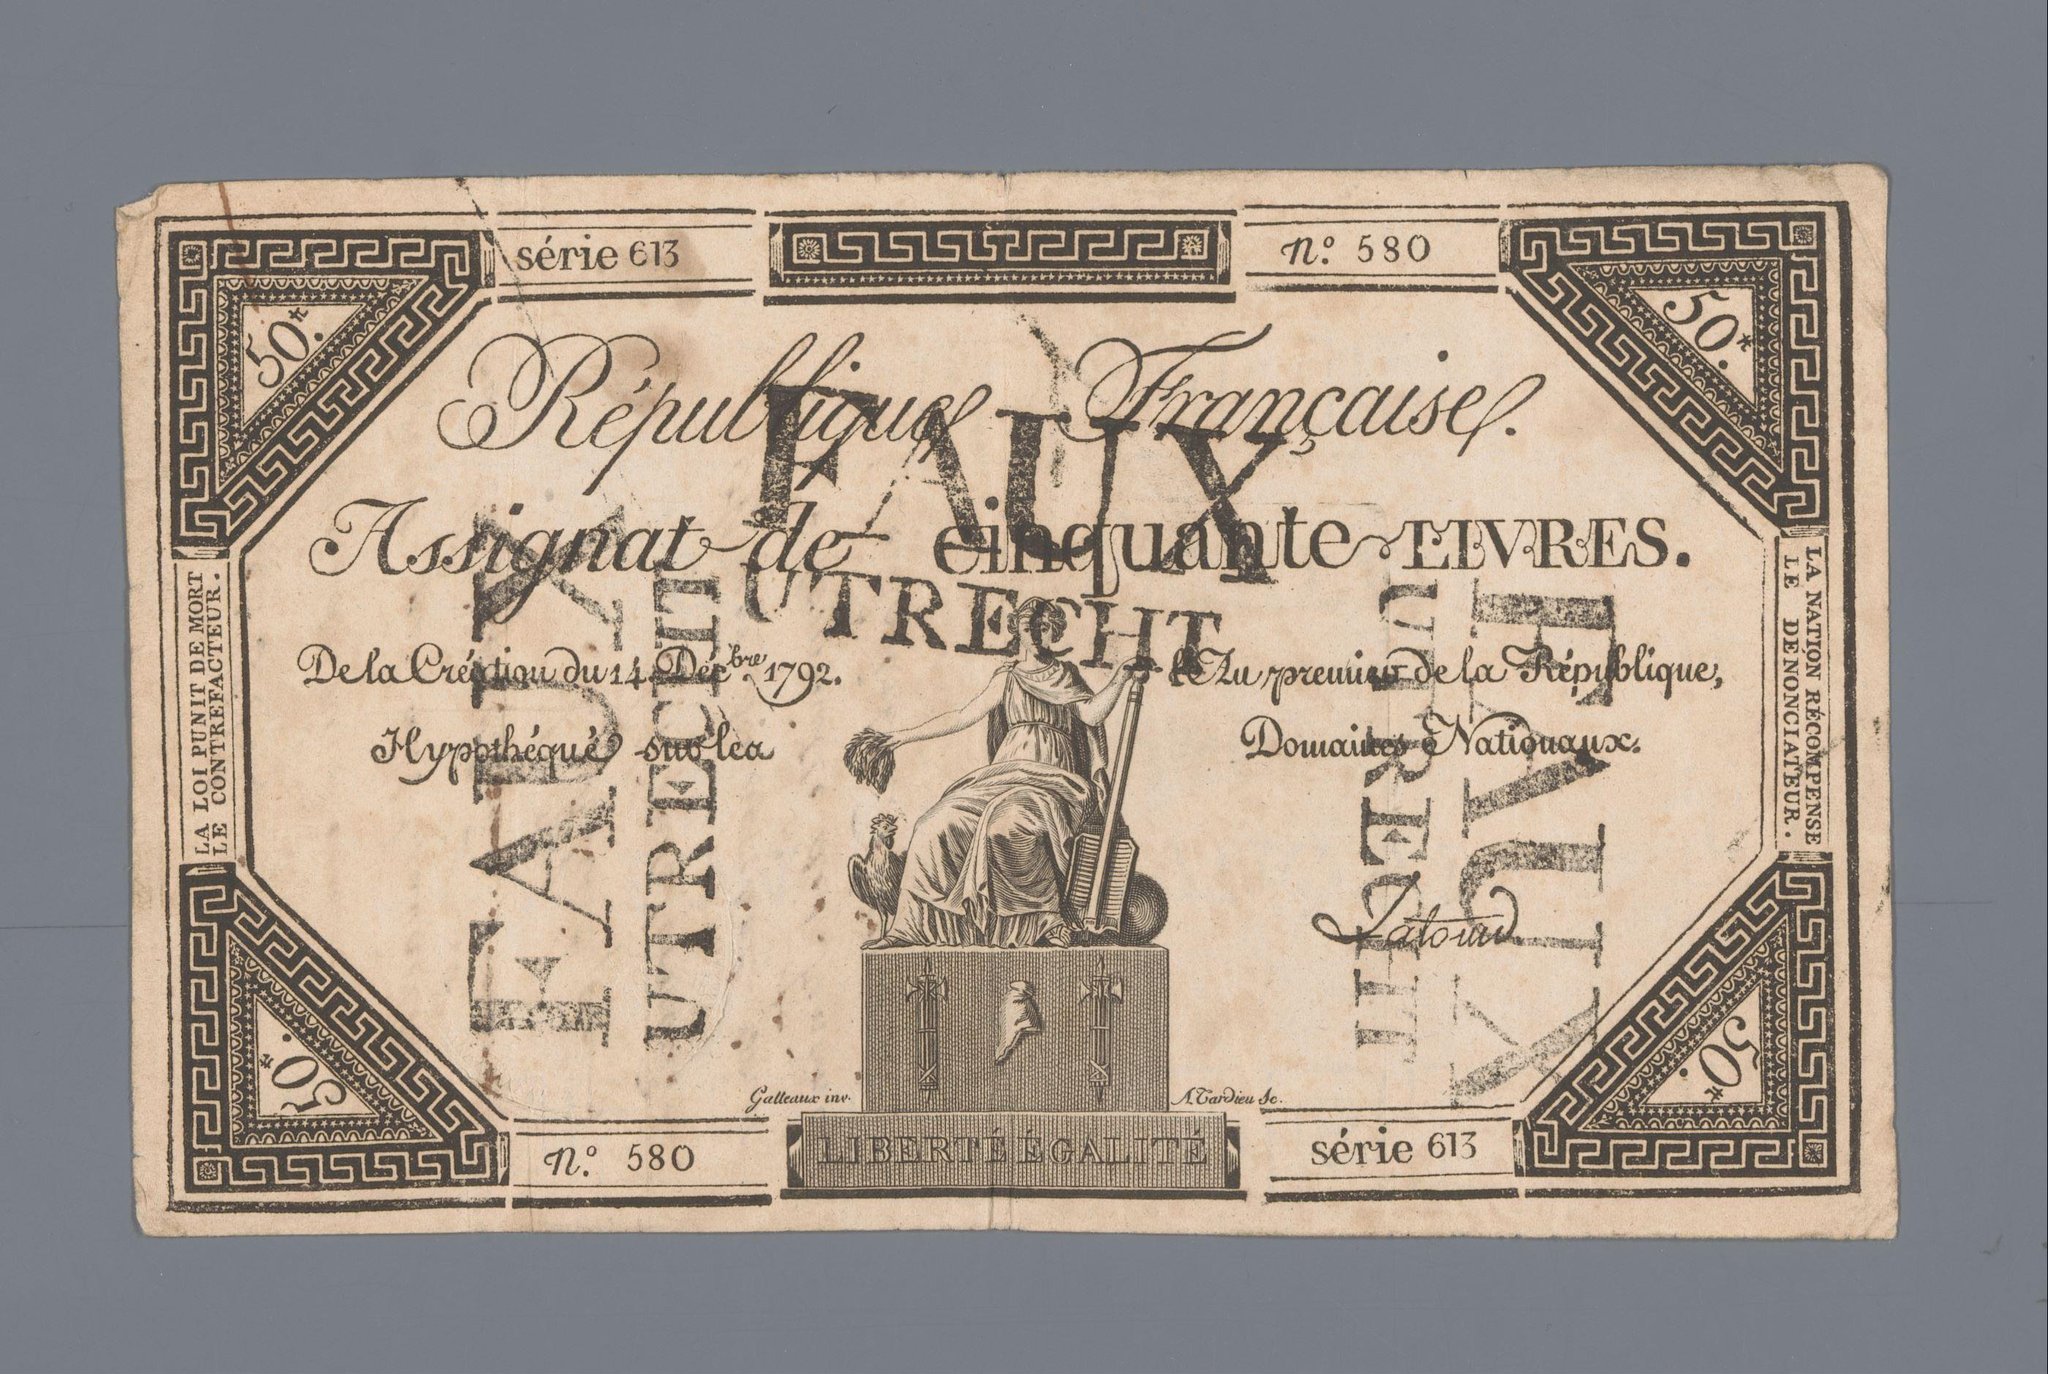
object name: assignat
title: Te Utrecht ongeldig gemaakte assignat van vijftig livres, serie 613, nr. 580 uitgegeven 14 december 1792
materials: paper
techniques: printing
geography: france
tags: utrecht, france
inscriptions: annotation: ‘Reçu cet Assignat en // echange de numeraire des // Ouvriers, qui ont travaillé // pour la Republique Francaise // H. Kluit, de // Rhynsaterwoude. // Officier Municipal pour // le Committé des Finances // de la ville d'Utrecht.’